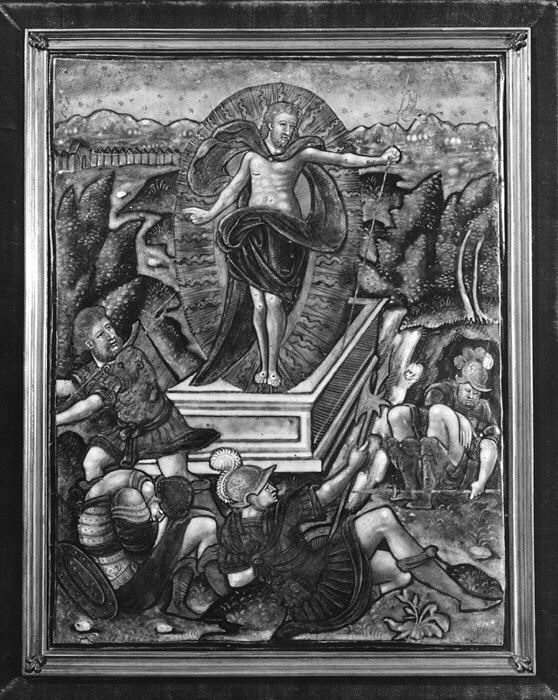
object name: plaque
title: The Resurrection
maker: jean i reymond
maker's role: enameler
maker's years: 1560-1603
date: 1580-1600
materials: copper, enamel, gilt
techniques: painting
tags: soldiers,christ,resurrection